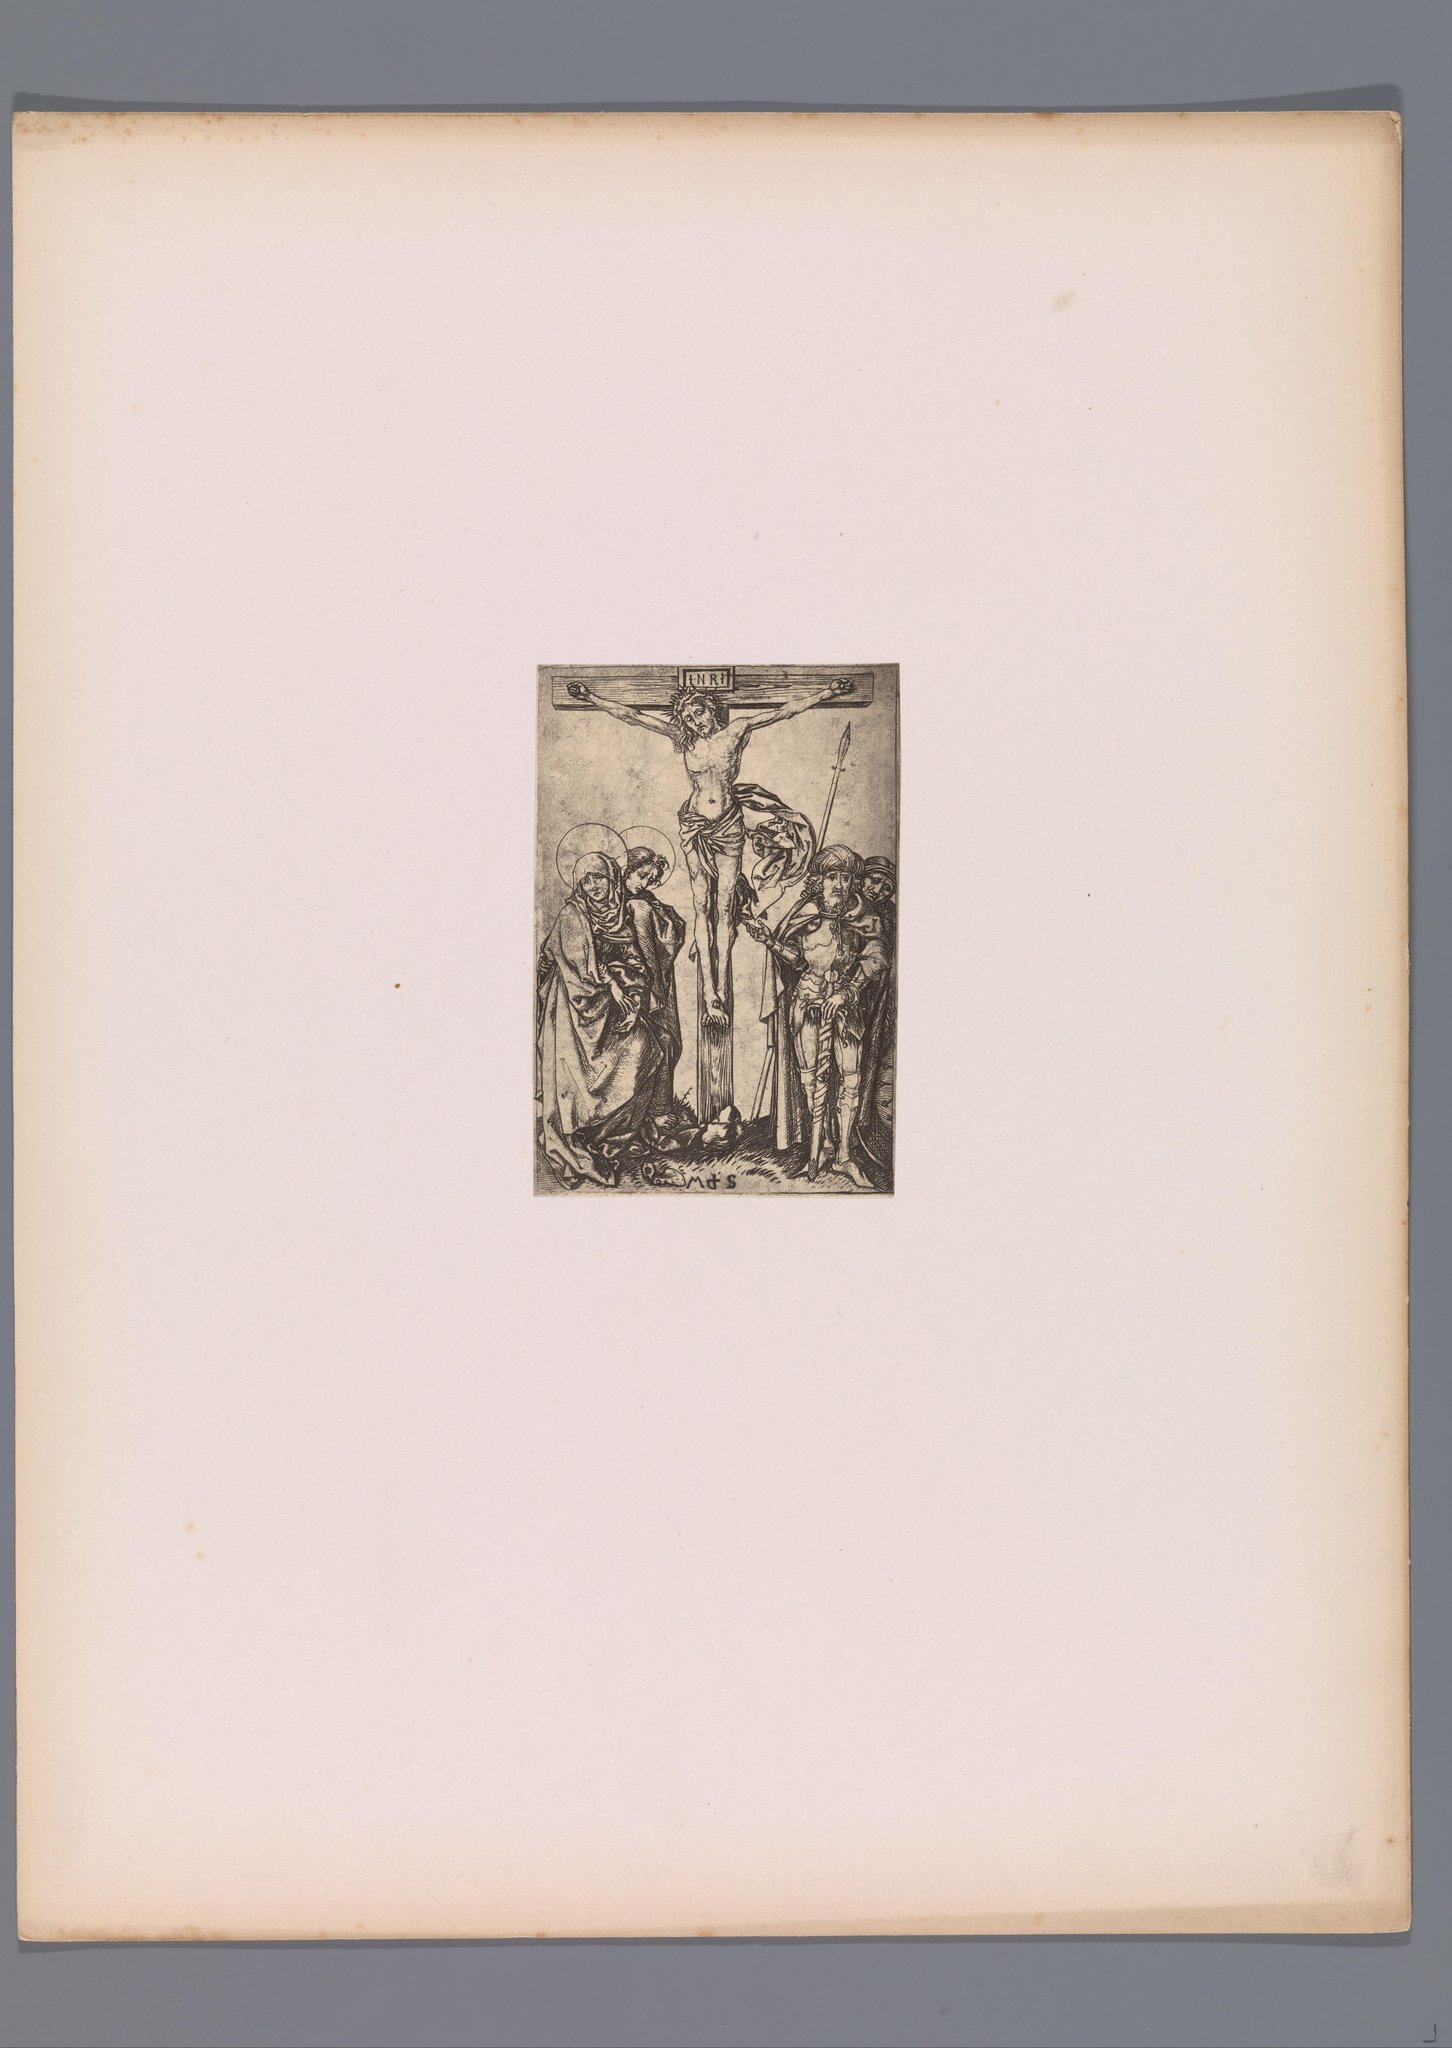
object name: photomechanical print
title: Reproductie van een prent van de kruisiging door Martin Schongauer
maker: martin schongauer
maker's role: print maker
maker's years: 1430-1491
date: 1867-1872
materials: paper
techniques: woodburytype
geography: brussels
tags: crucified christ, with particular persons under the cross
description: Deze prent maakt deel uit van een omslag met 24 prenten op 24 bladen.